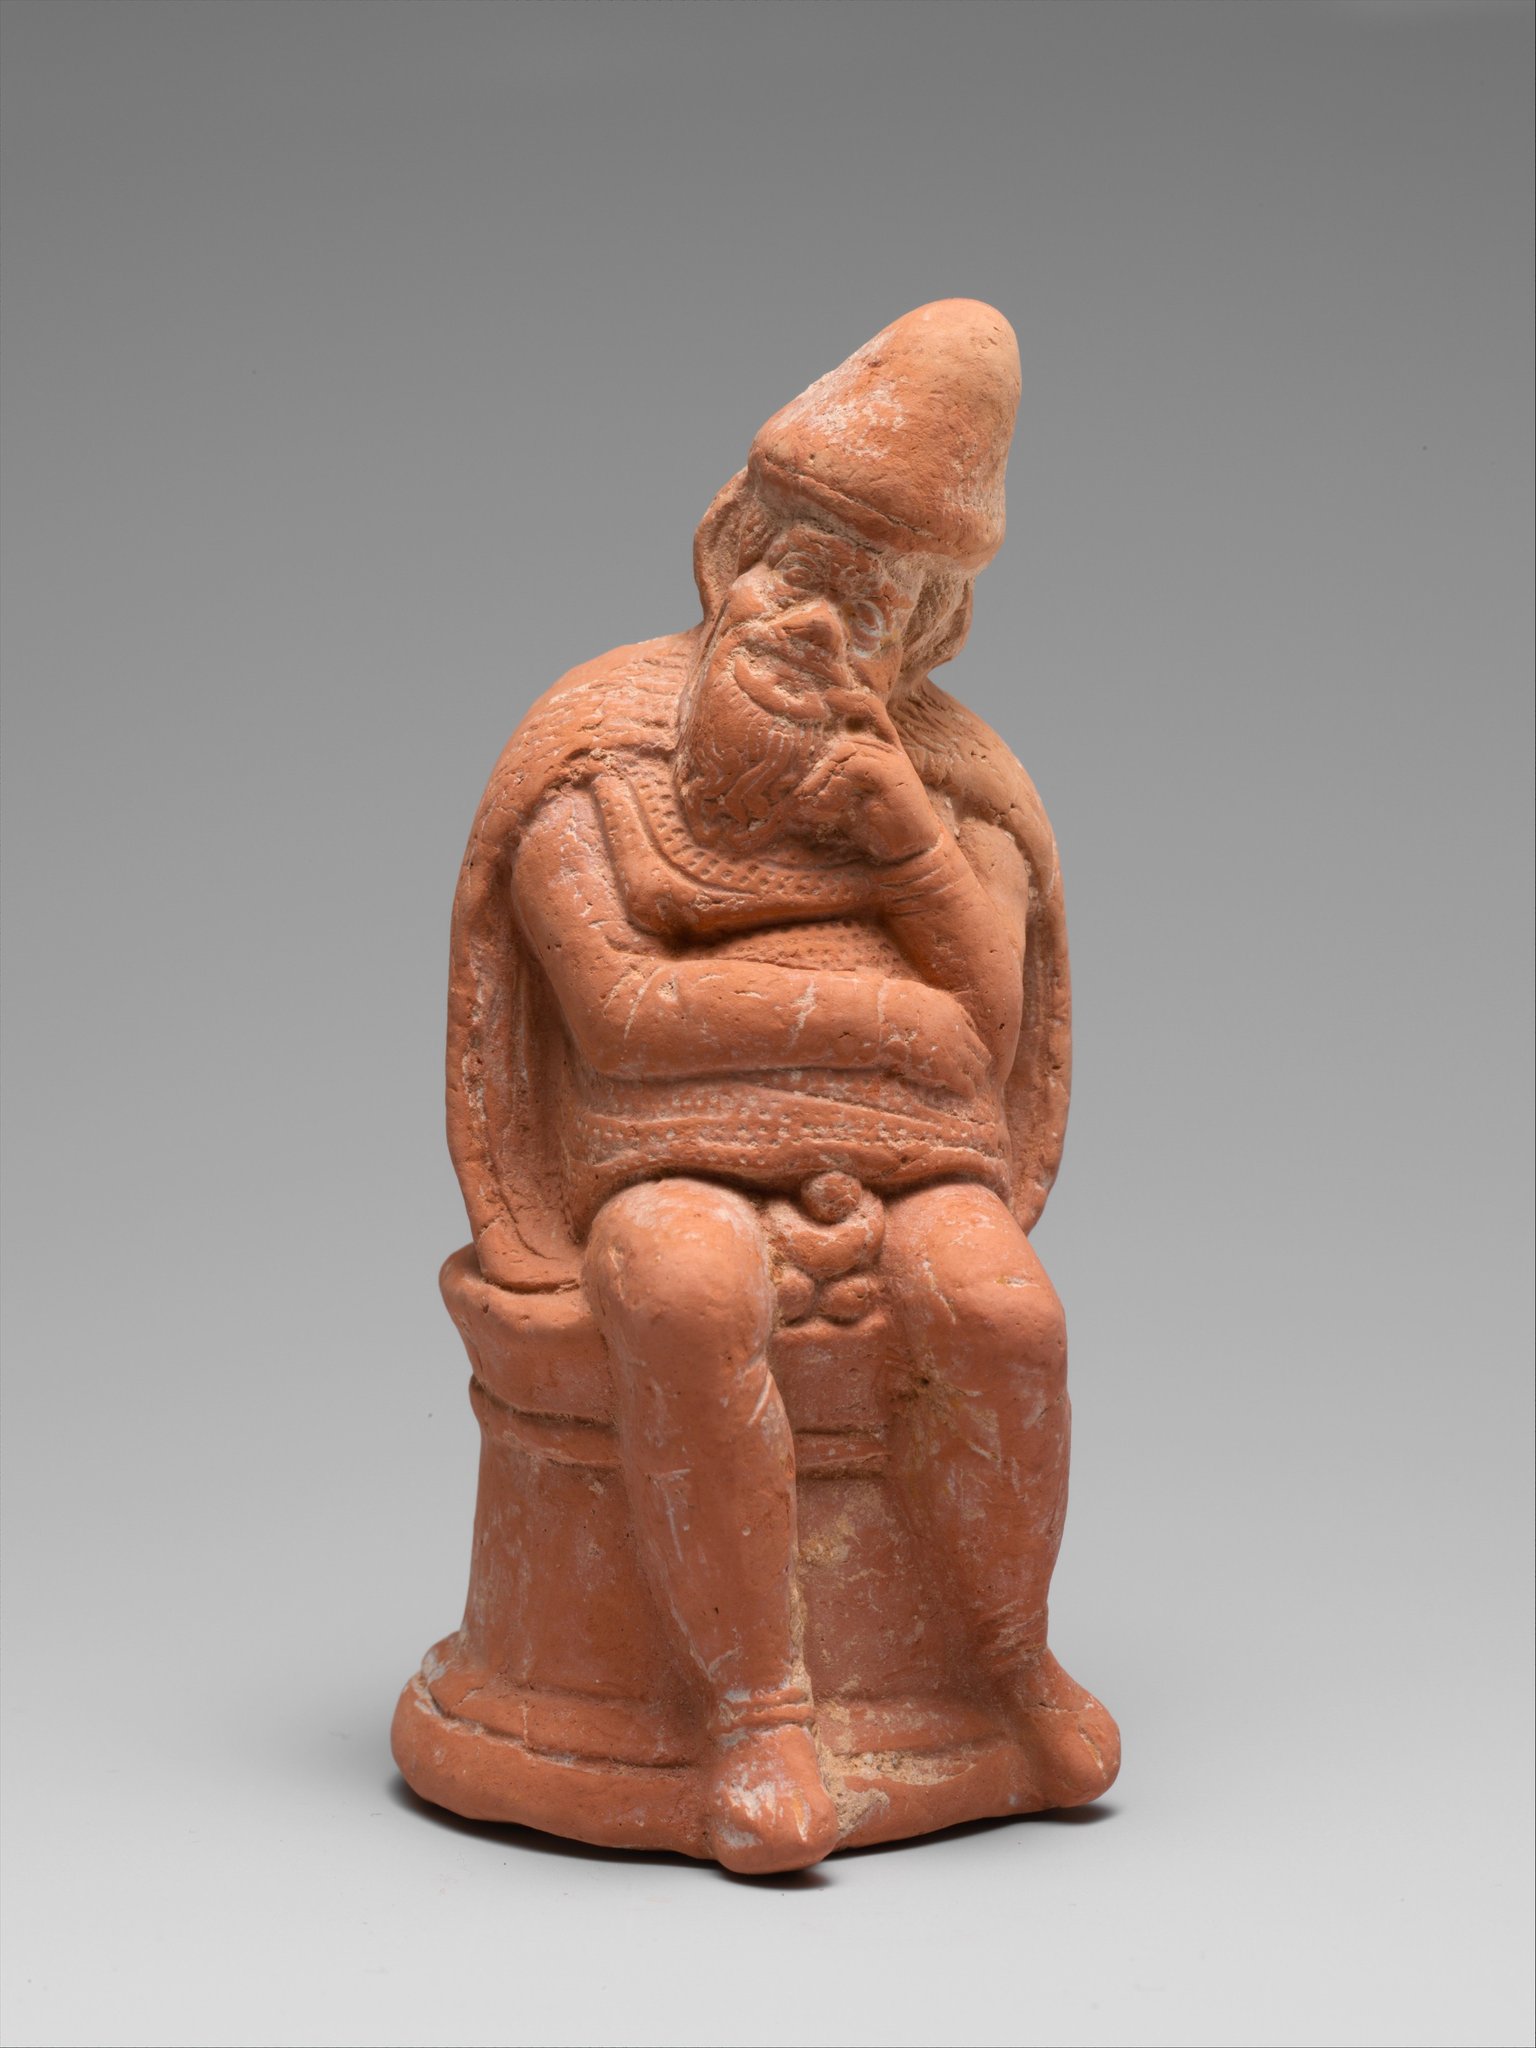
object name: statuette of an actor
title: Terracotta statuette of an actor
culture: greek, attic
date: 434-368 BCE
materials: terracotta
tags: masks,men,actors